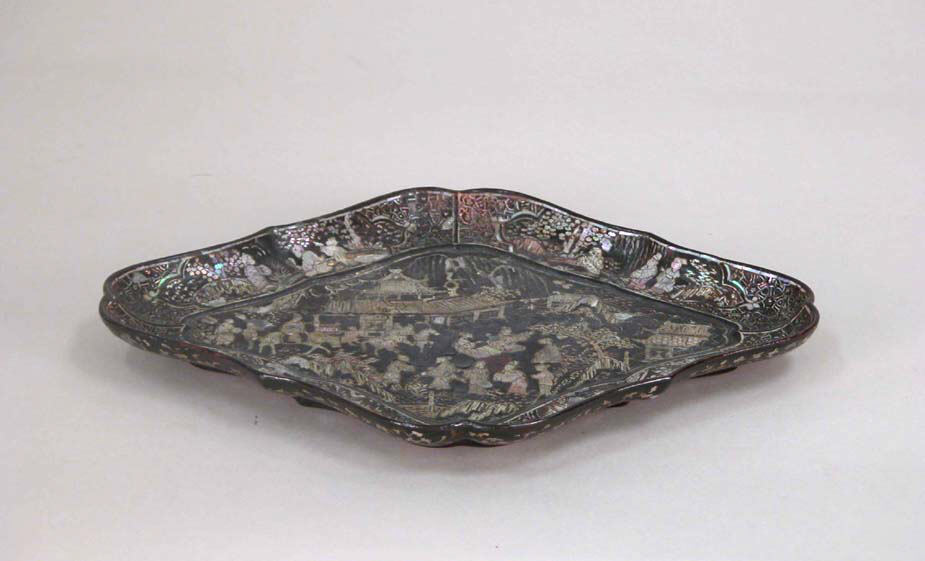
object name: tray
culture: chinese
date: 1401-1600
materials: lacquer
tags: human figures,horses